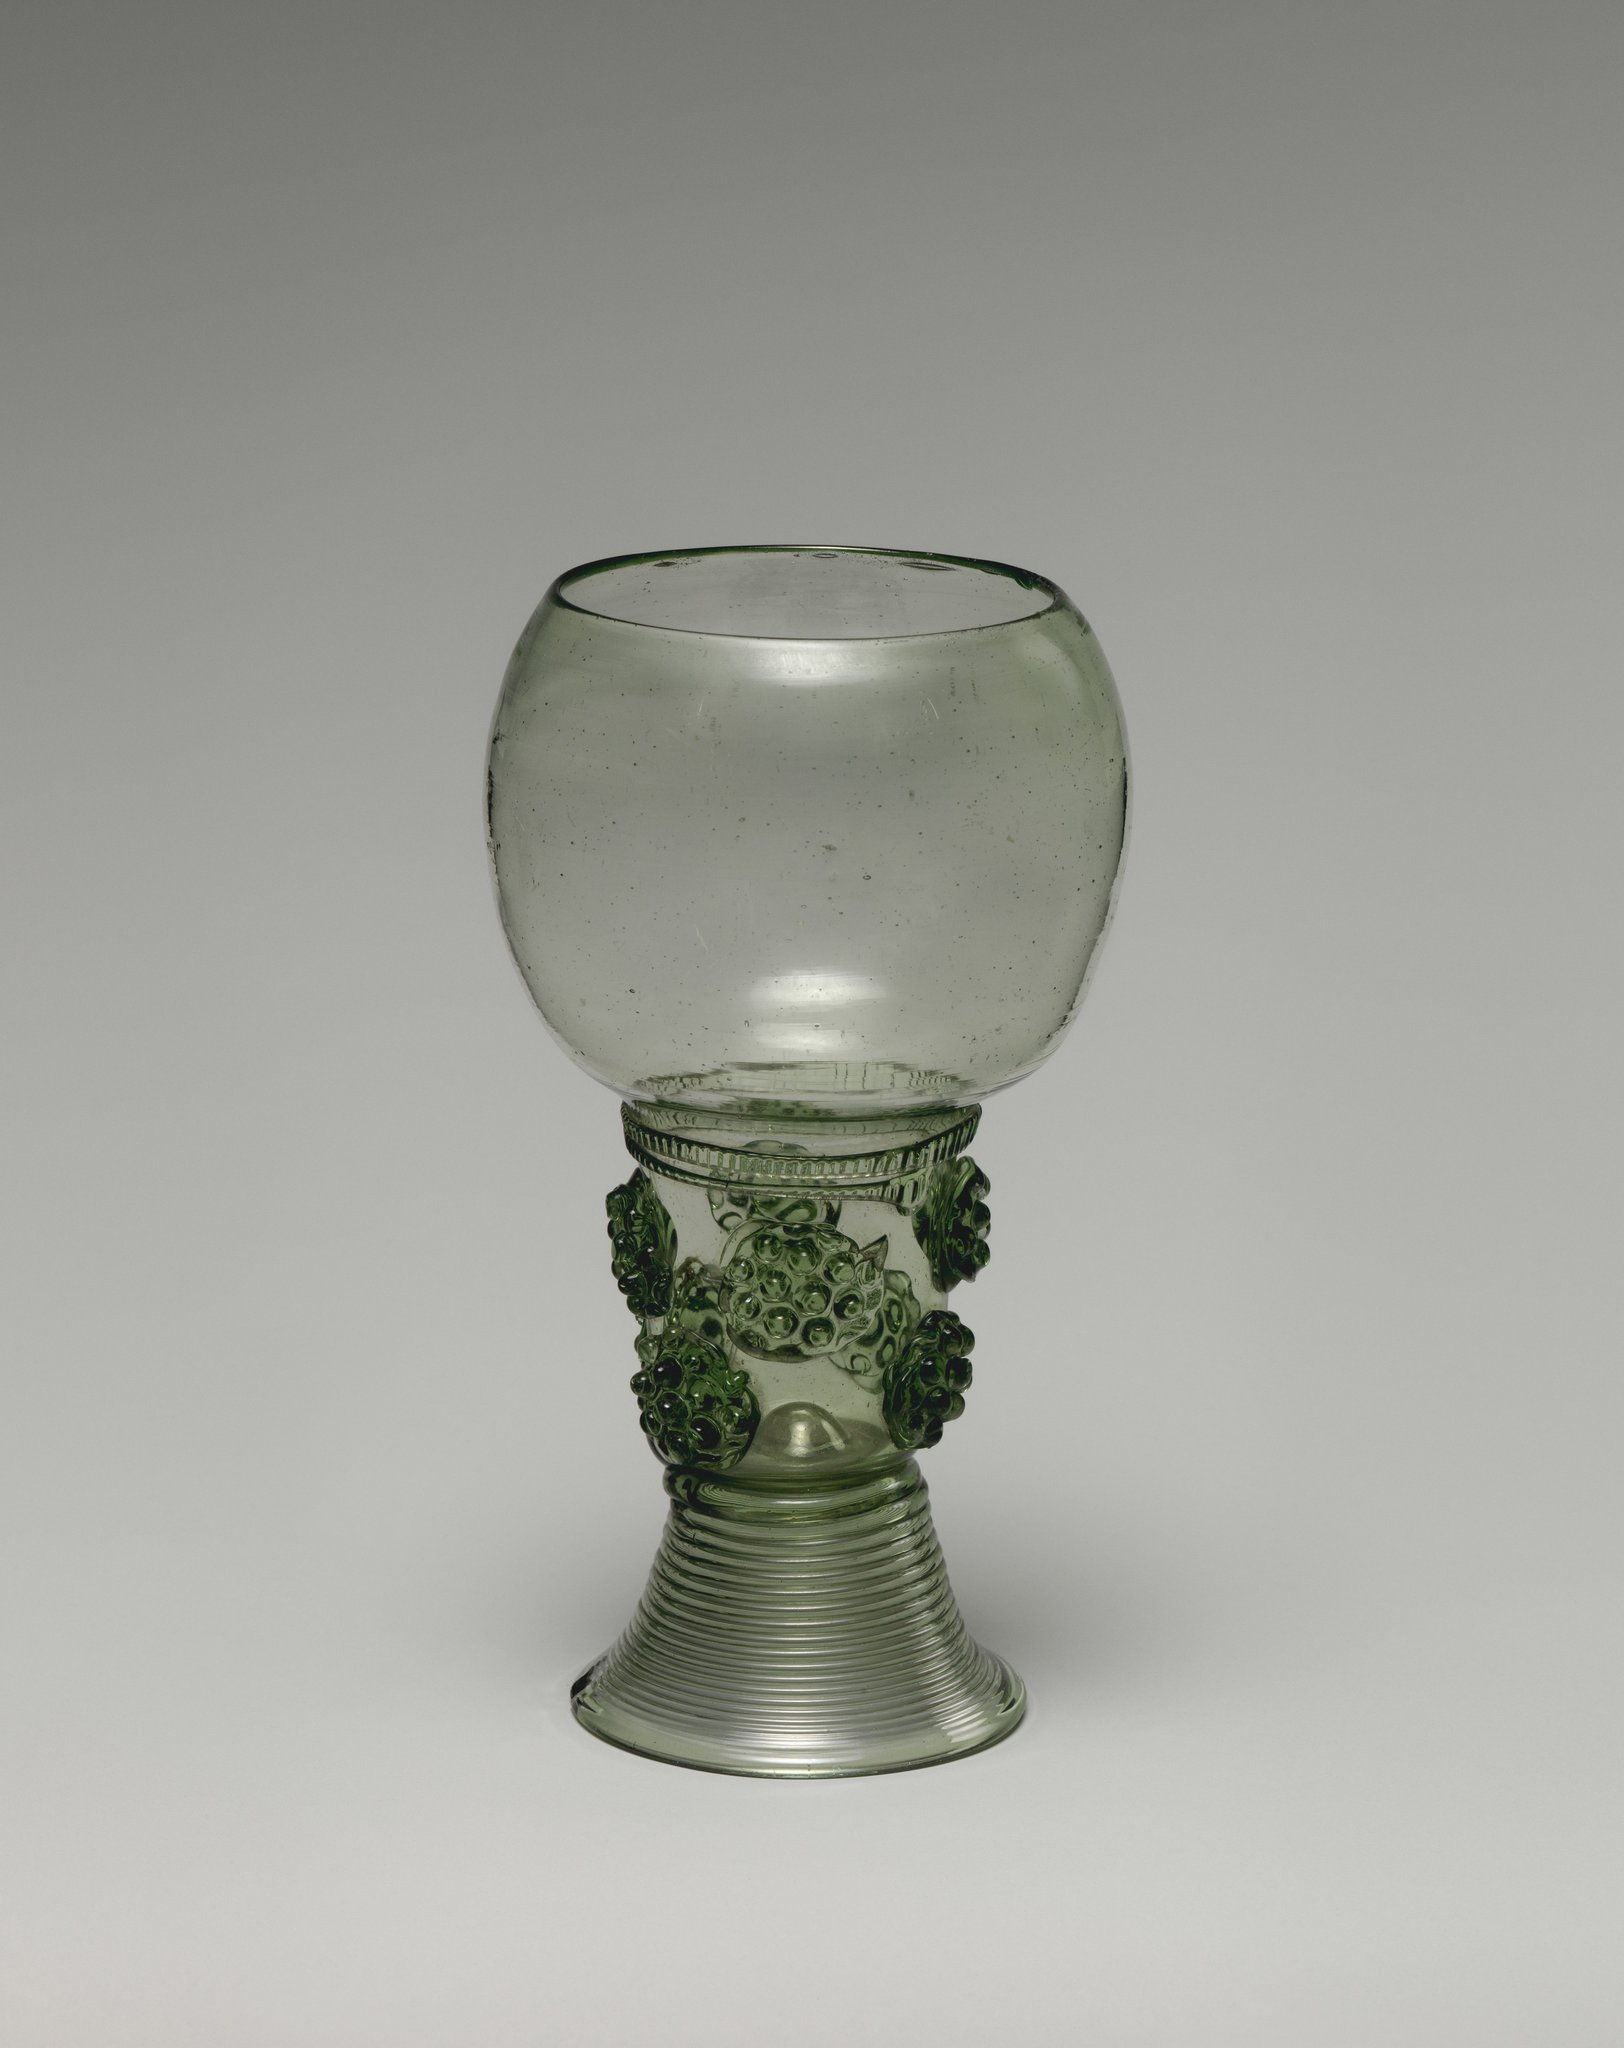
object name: roemer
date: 1667-1733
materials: glass